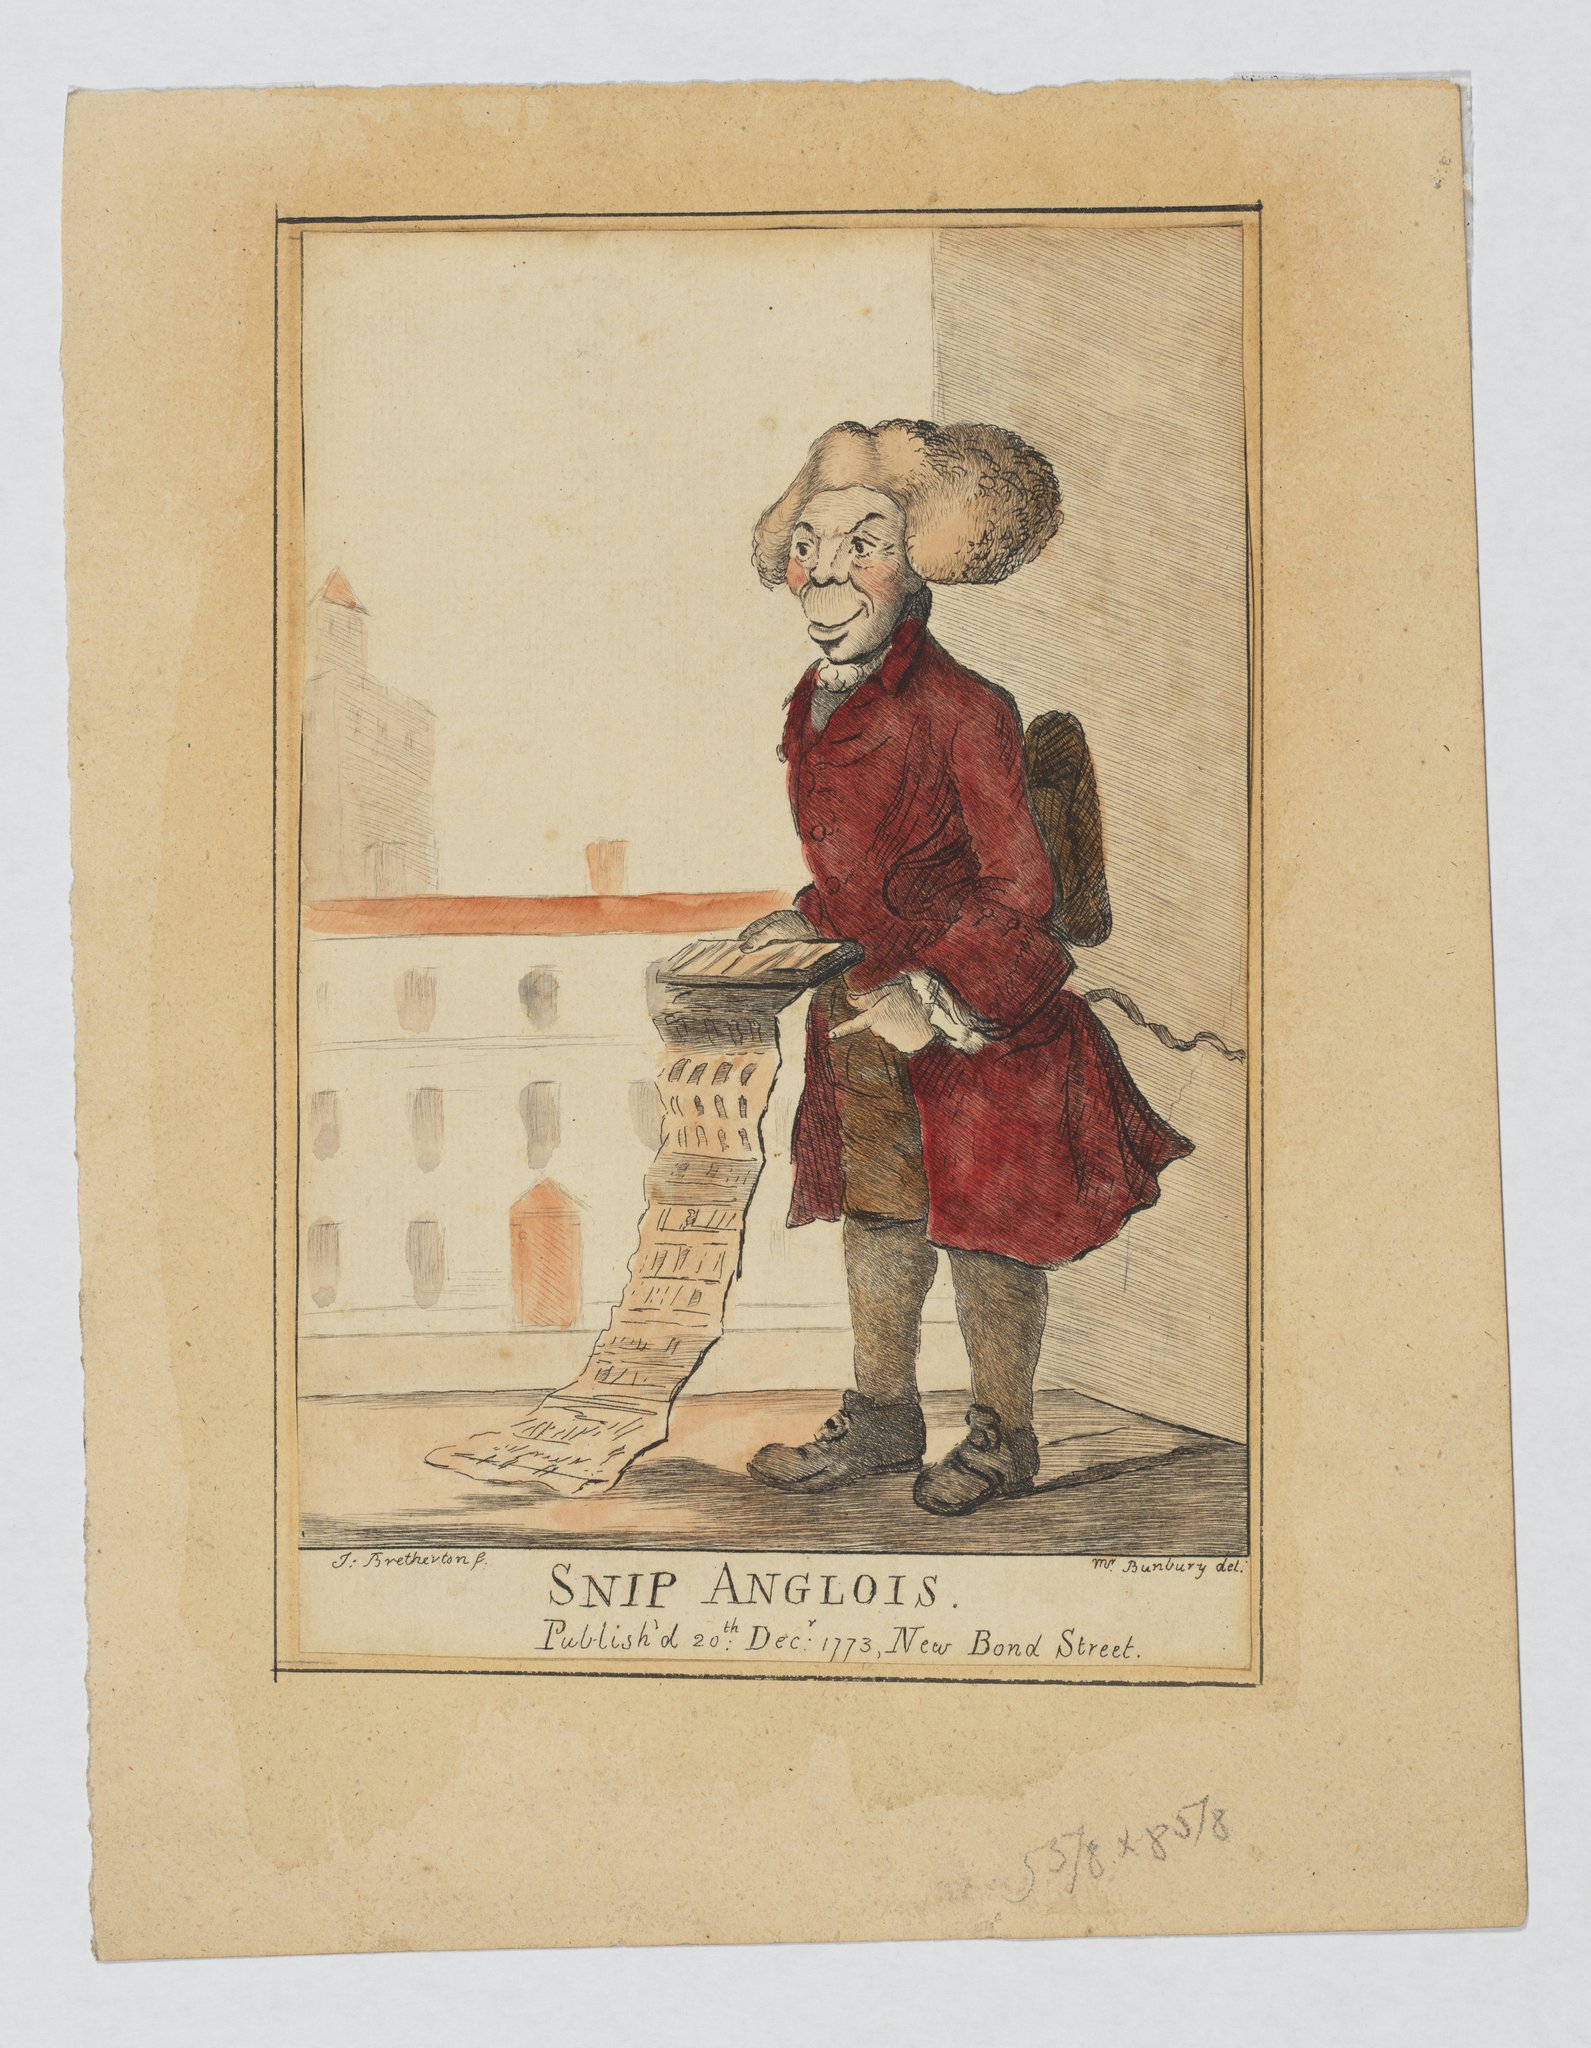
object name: print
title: Snip Anglois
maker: james bretherton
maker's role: etcher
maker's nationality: british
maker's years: 1750-1799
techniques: etching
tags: satire,men